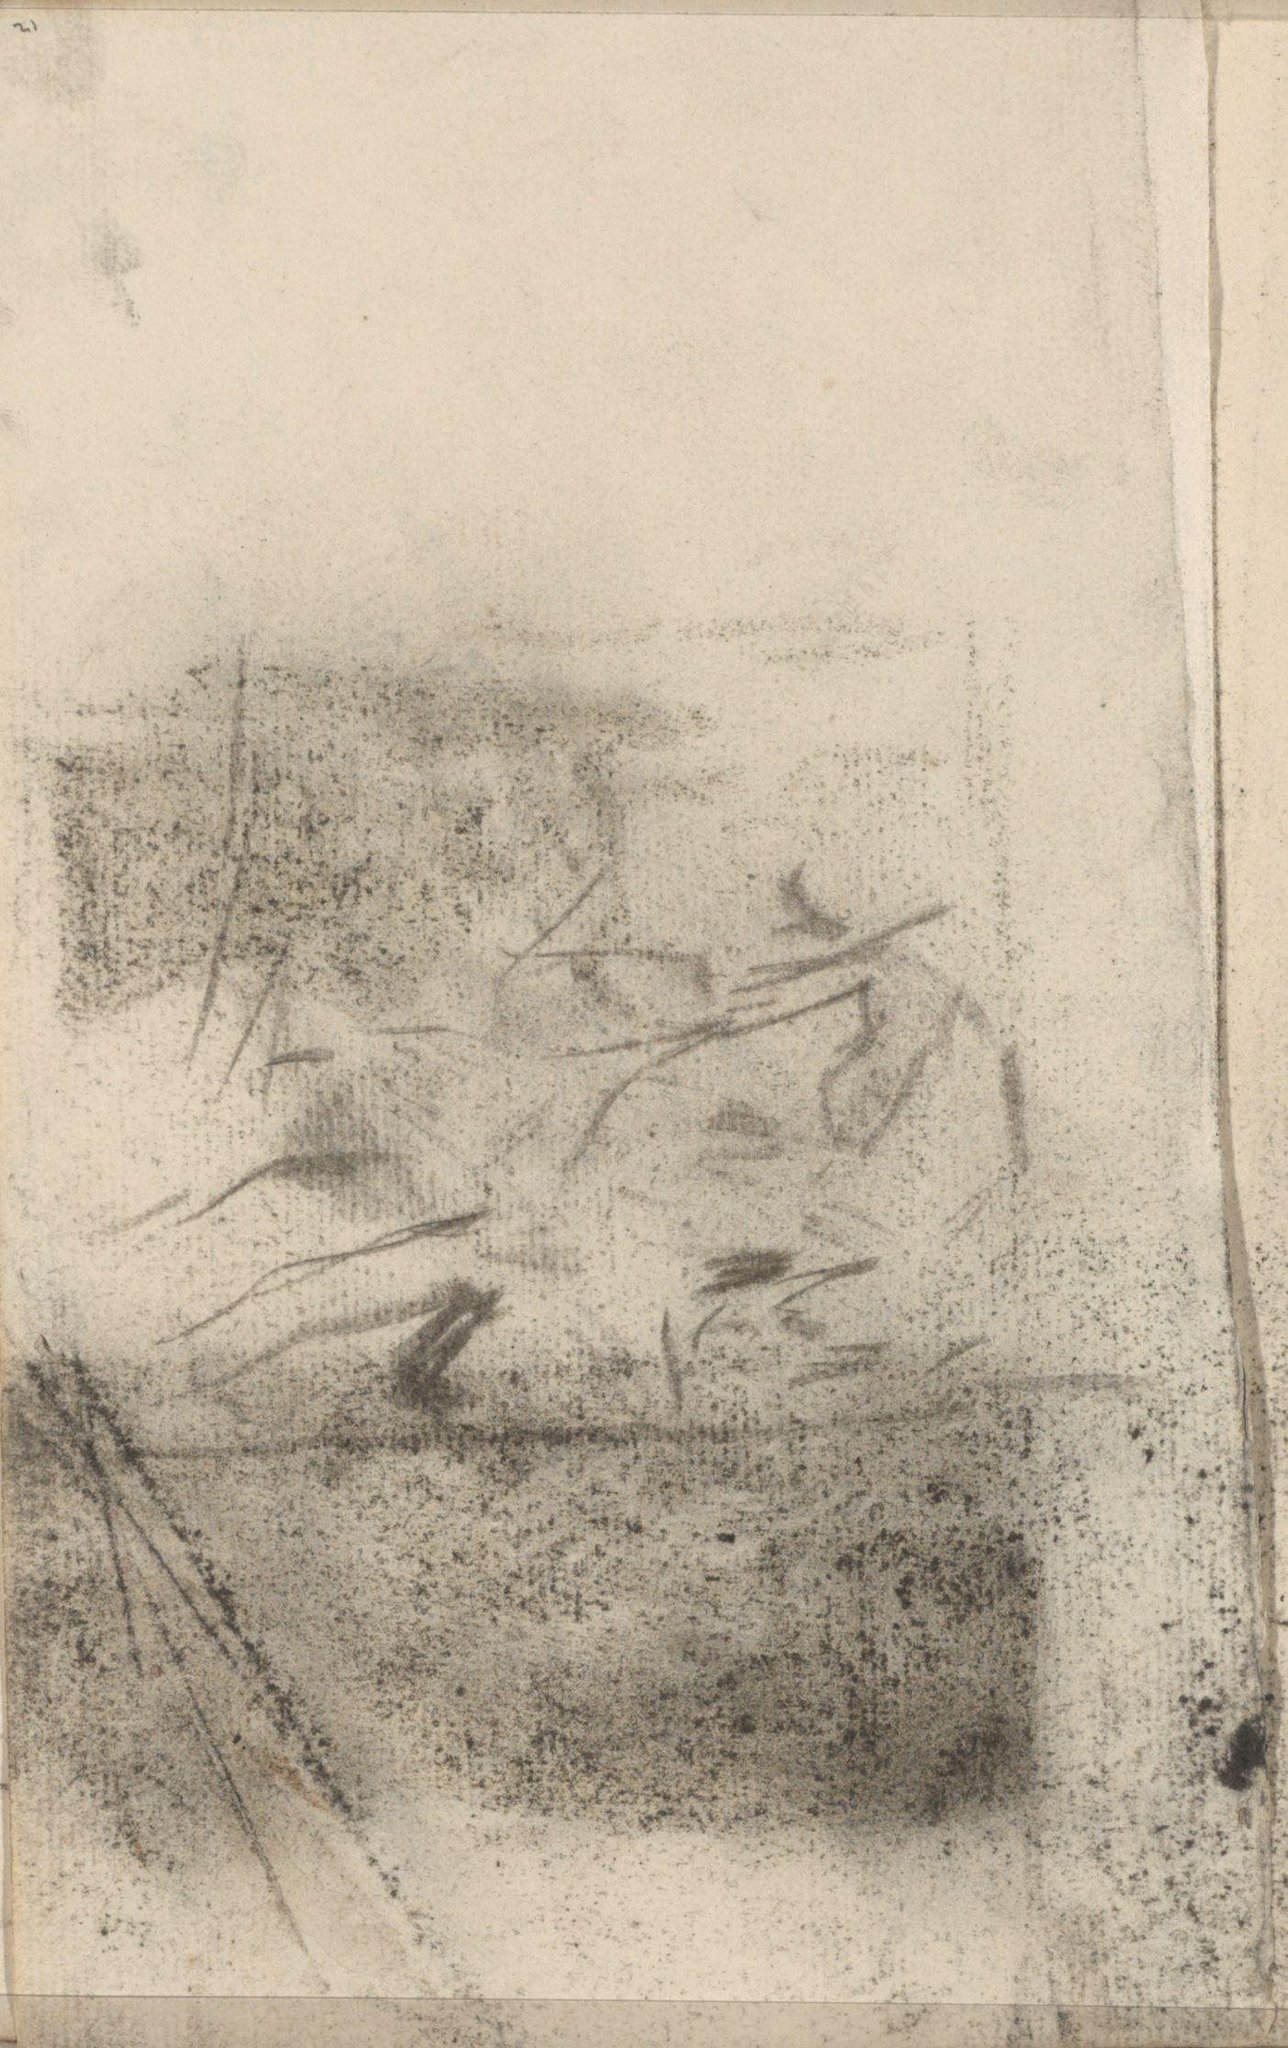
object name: sketchbook leaf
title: Studie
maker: george hendrik breitner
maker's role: draughtsman, painter, print maker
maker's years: 1857-1923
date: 1884-1886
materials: chalk, paper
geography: the hague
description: Pagina 21 uit een schetsboek met 29 bladen.